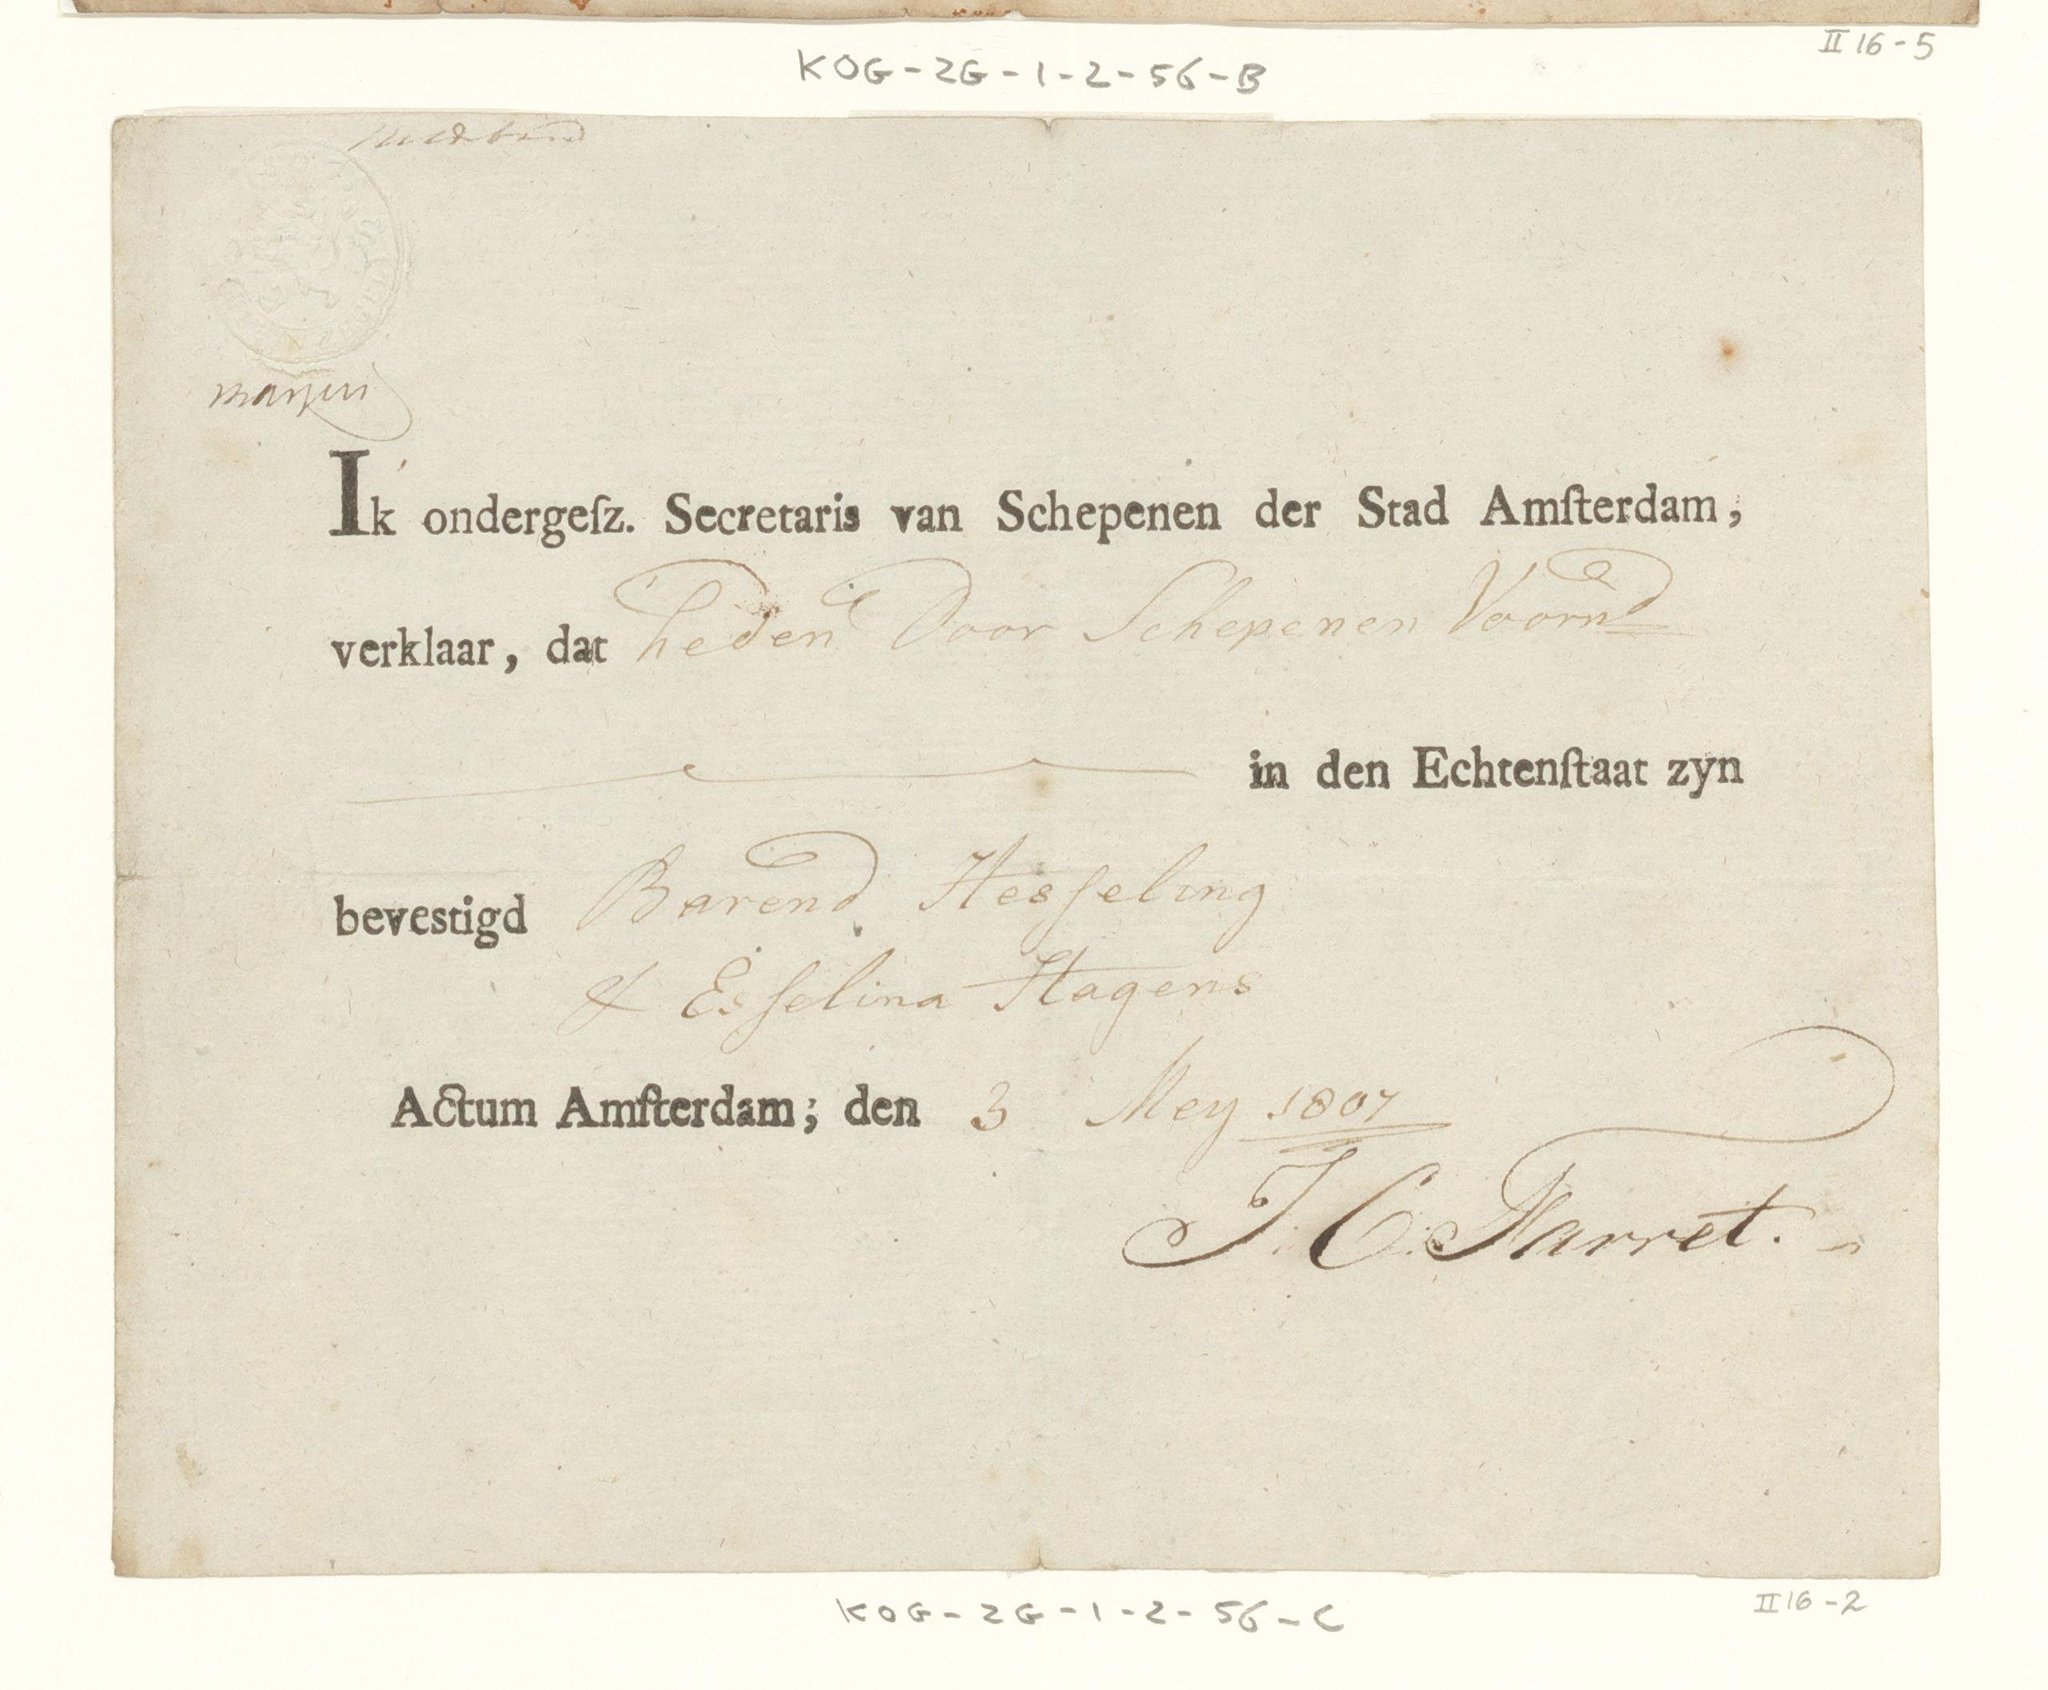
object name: document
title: Bevestiging van het huwelijk tussen Barend Hesseling en Esselina Hagens, 1807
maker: Anonymous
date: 1807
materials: ink, paper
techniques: blind stamped, letterpress printing, pen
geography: amsterdam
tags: registration bureau, civil registry, marriage contract, amsterdam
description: Bevestiging van de huwelijksvoltrekking tussen Barend Hesseling en Esselina Hagens, Amsterdam, 3 mei 1807. Voorgedrukt formulier met de hand met pen ingevuld. Linksboven een blindstempel voor de voldane betaling. Onderwerpsrubrieken binnen de Atlas Zeden en Gewoonten: Regeering, Burgerlijke Stand.